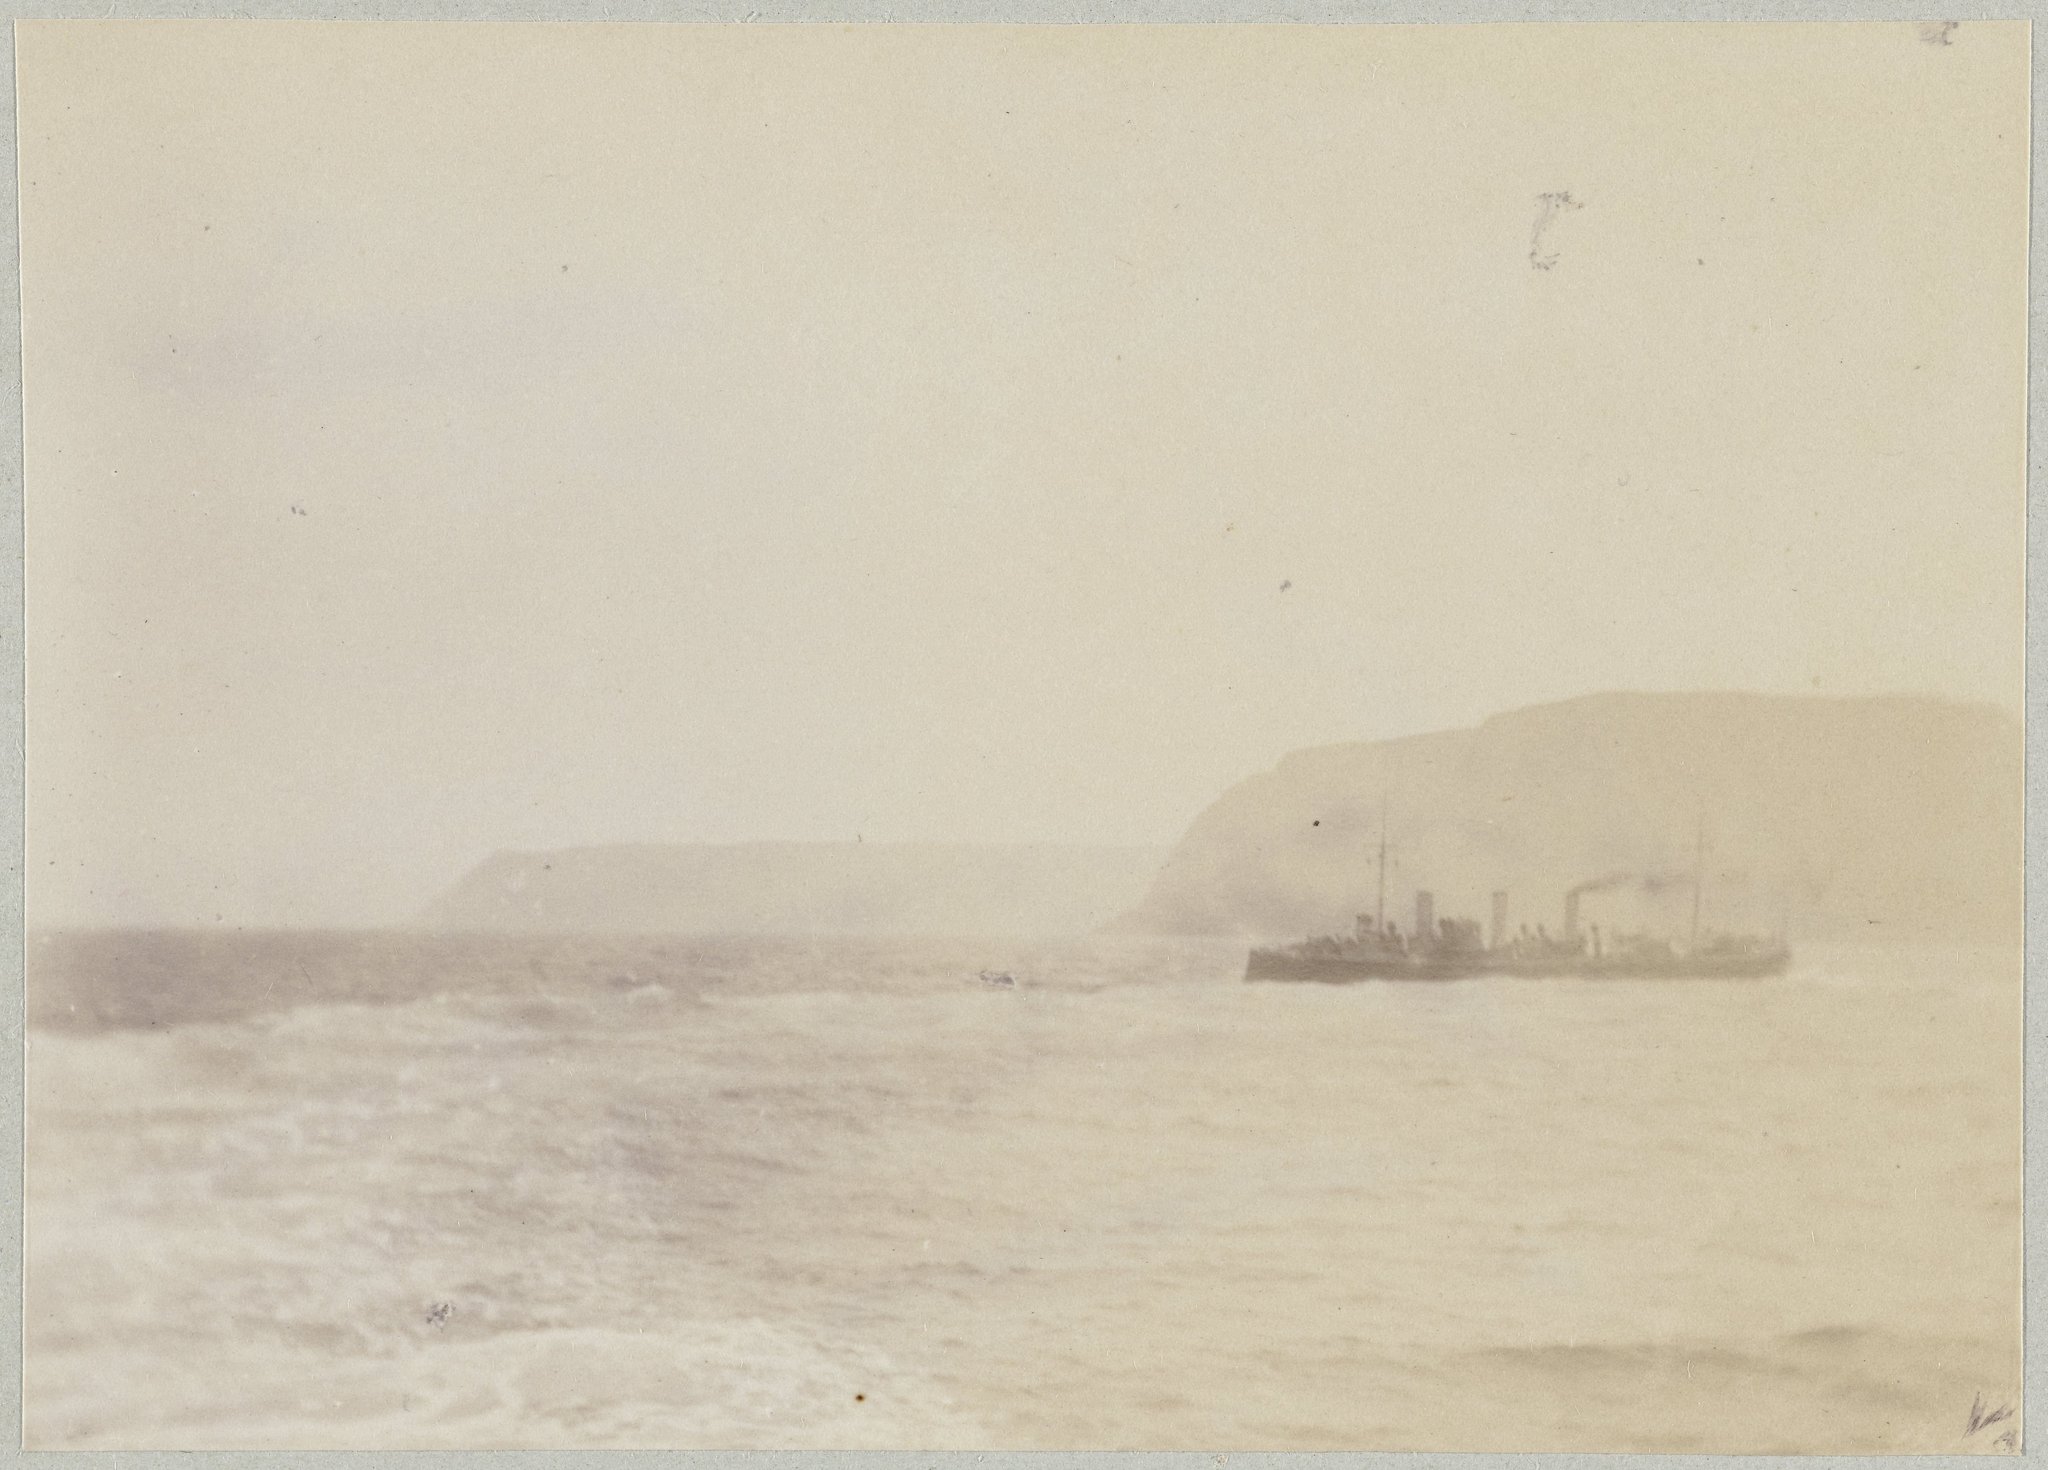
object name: photograph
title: Stoomboot op zee langs de Noorse kust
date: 1807-1889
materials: cardboard, paper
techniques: albumen print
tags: wilhelm ii (keizer van duitsland), norway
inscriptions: number: ‘28’